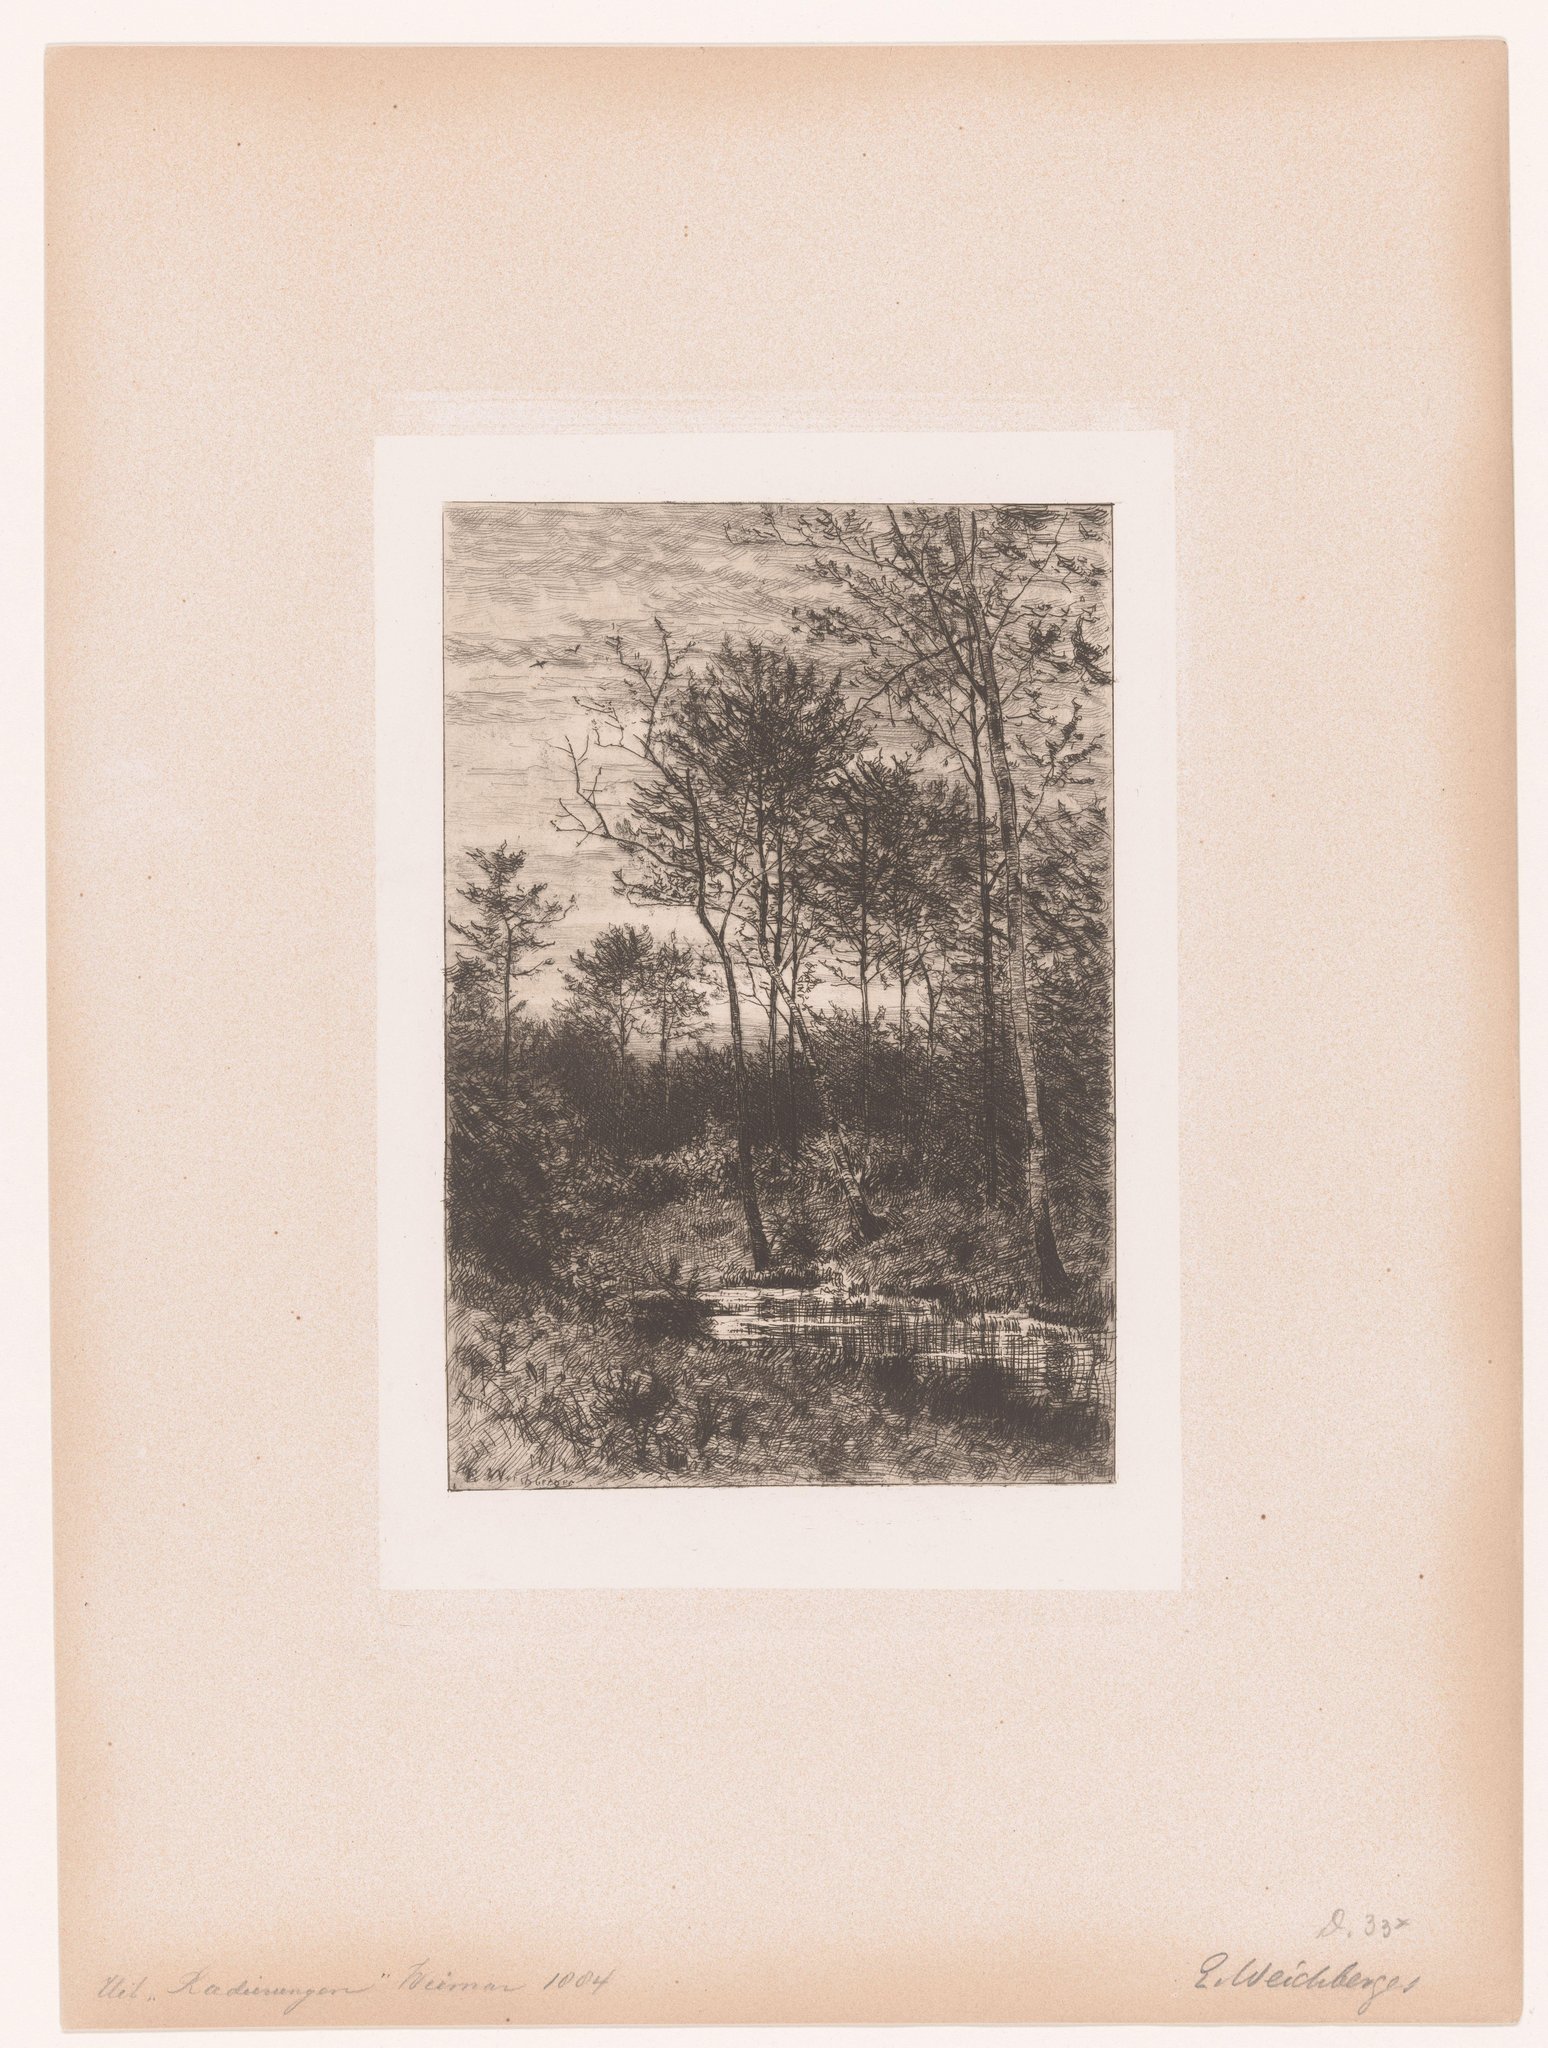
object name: print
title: Bos met een vijver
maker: eduard weichberger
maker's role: print maker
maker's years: 1843-1913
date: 1884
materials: paper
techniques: etching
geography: weimar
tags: forest, wood, pond, pool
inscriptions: inscription: ‘Uit "Radierungen" Weimar 1884’, collector's mark: Lugt 2228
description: Prent maakt deel uit van een groep prenten die tussen 1880 en 1888 werd uitgegeven door het Gesellschaft für Radierkunst te Weimar.